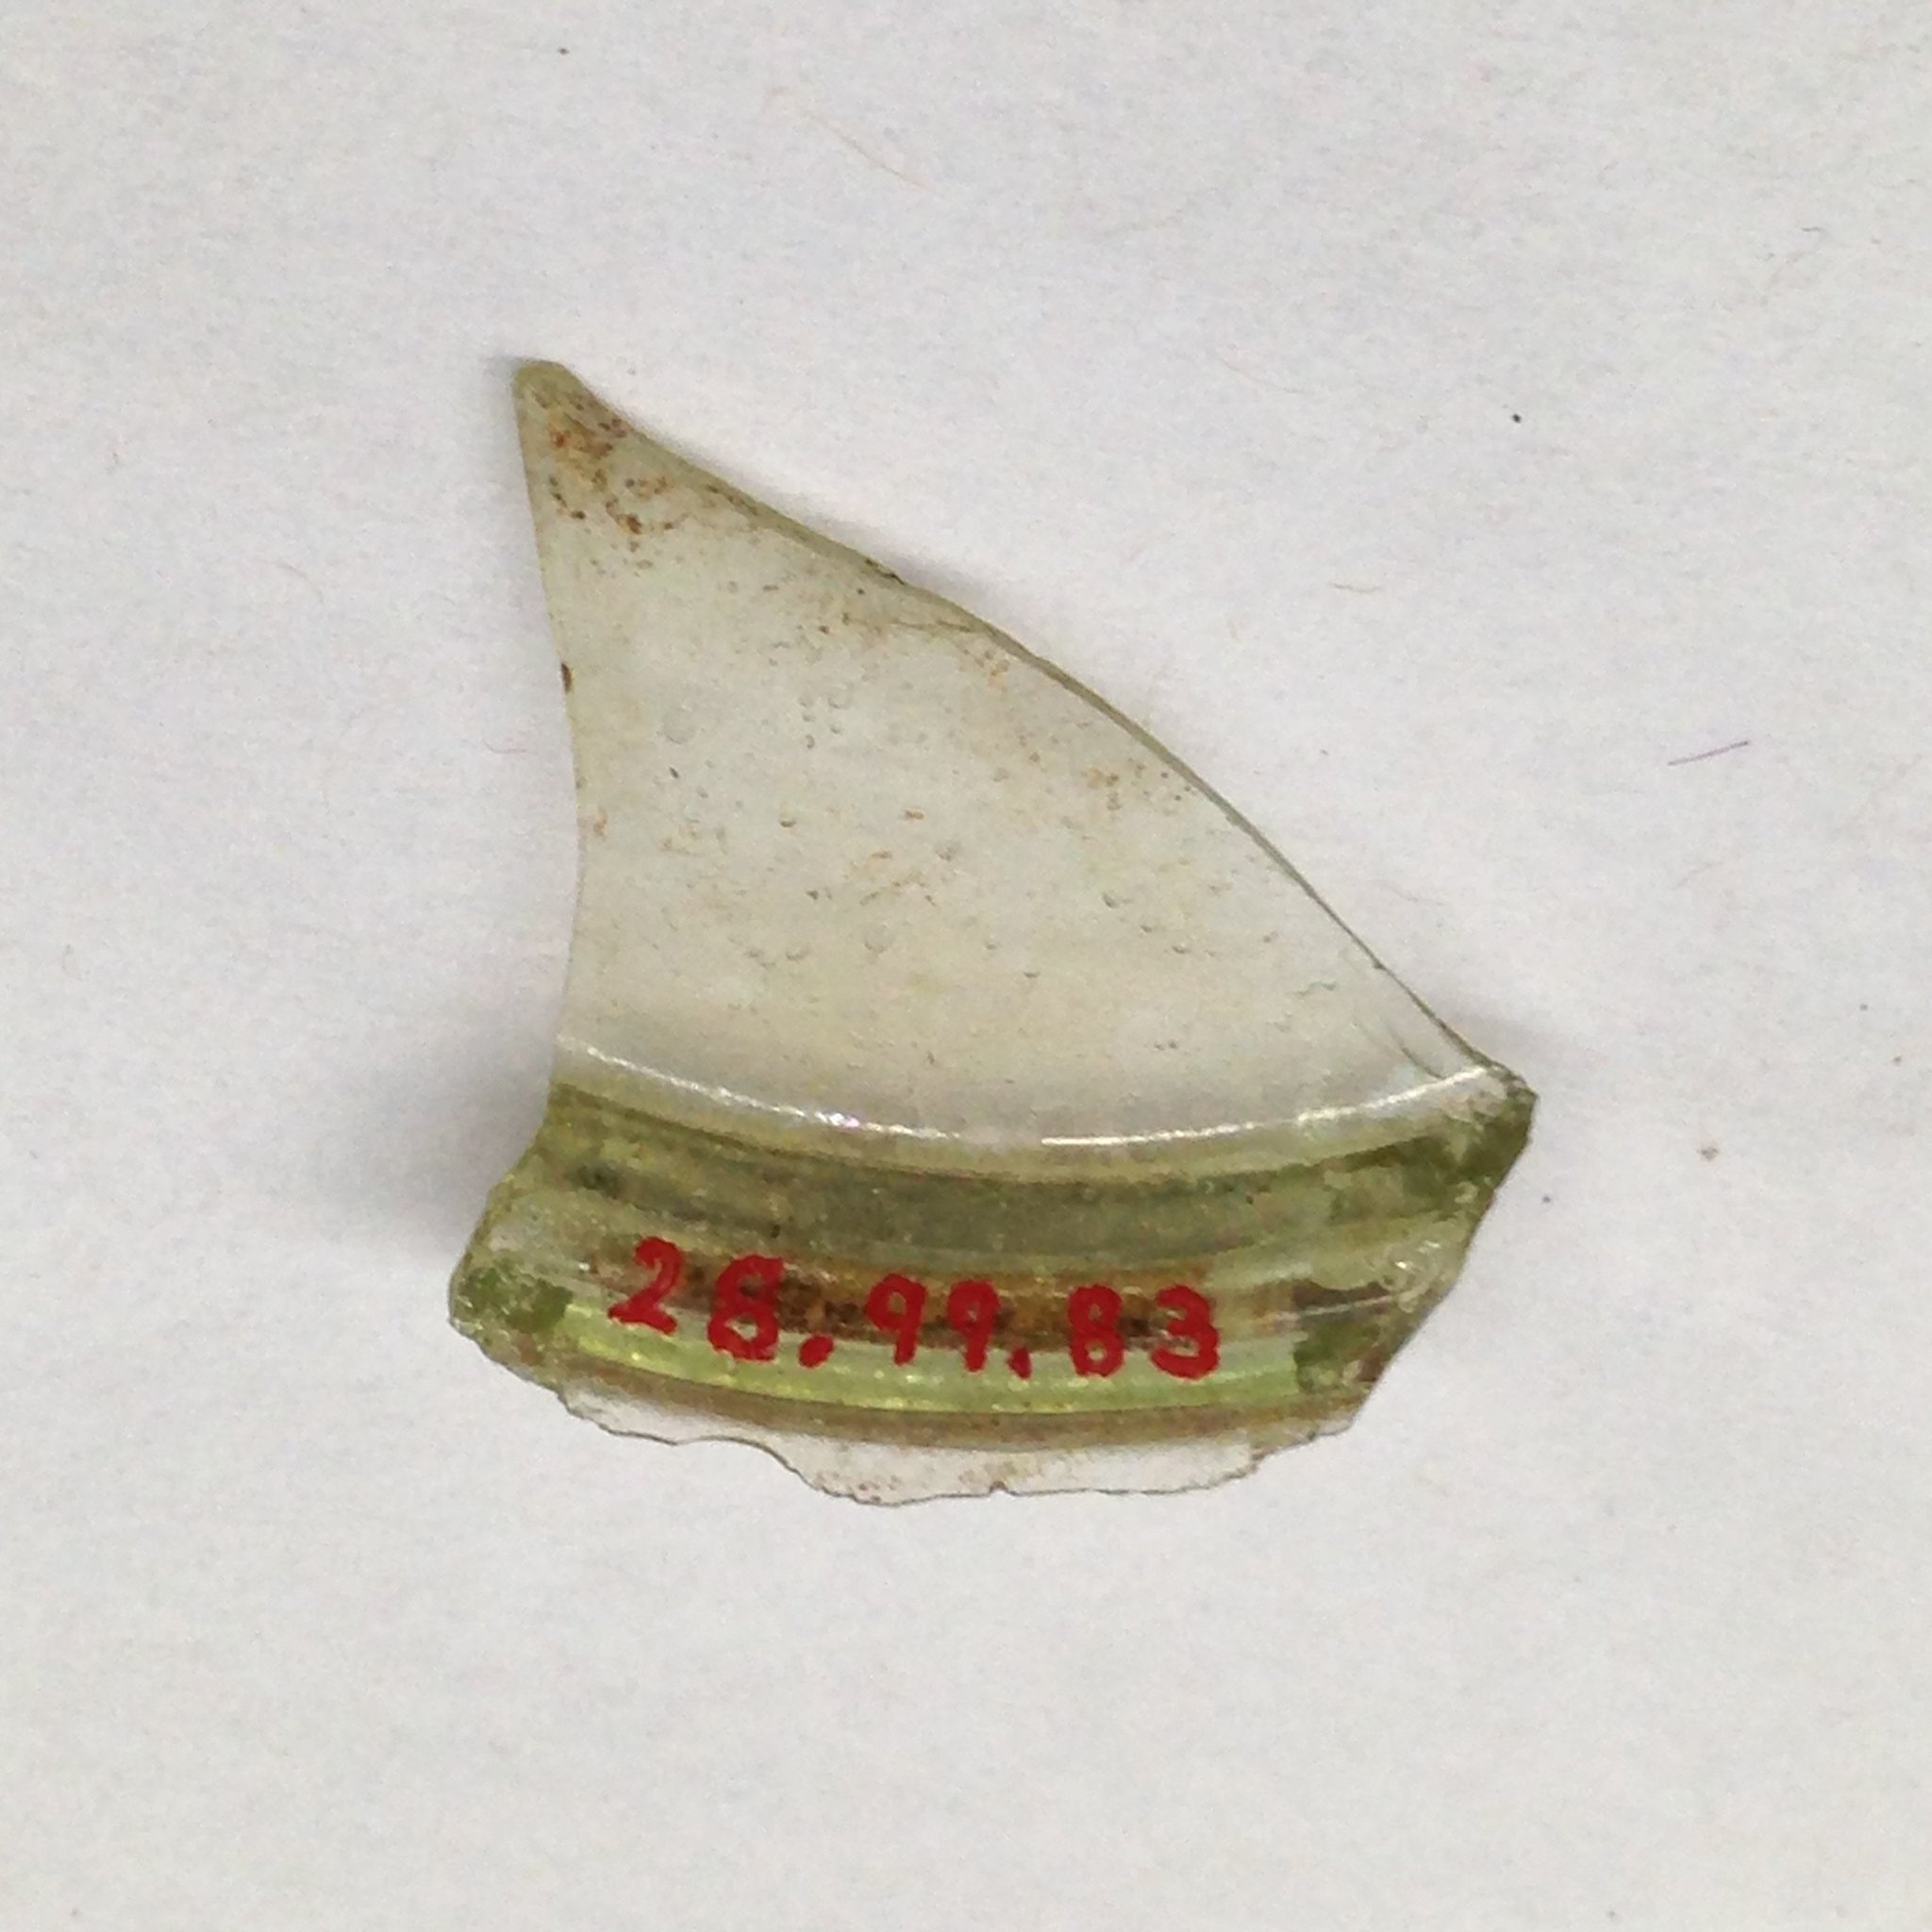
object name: fragment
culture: european or middle eastern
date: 1150-1250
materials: ceramic, glass